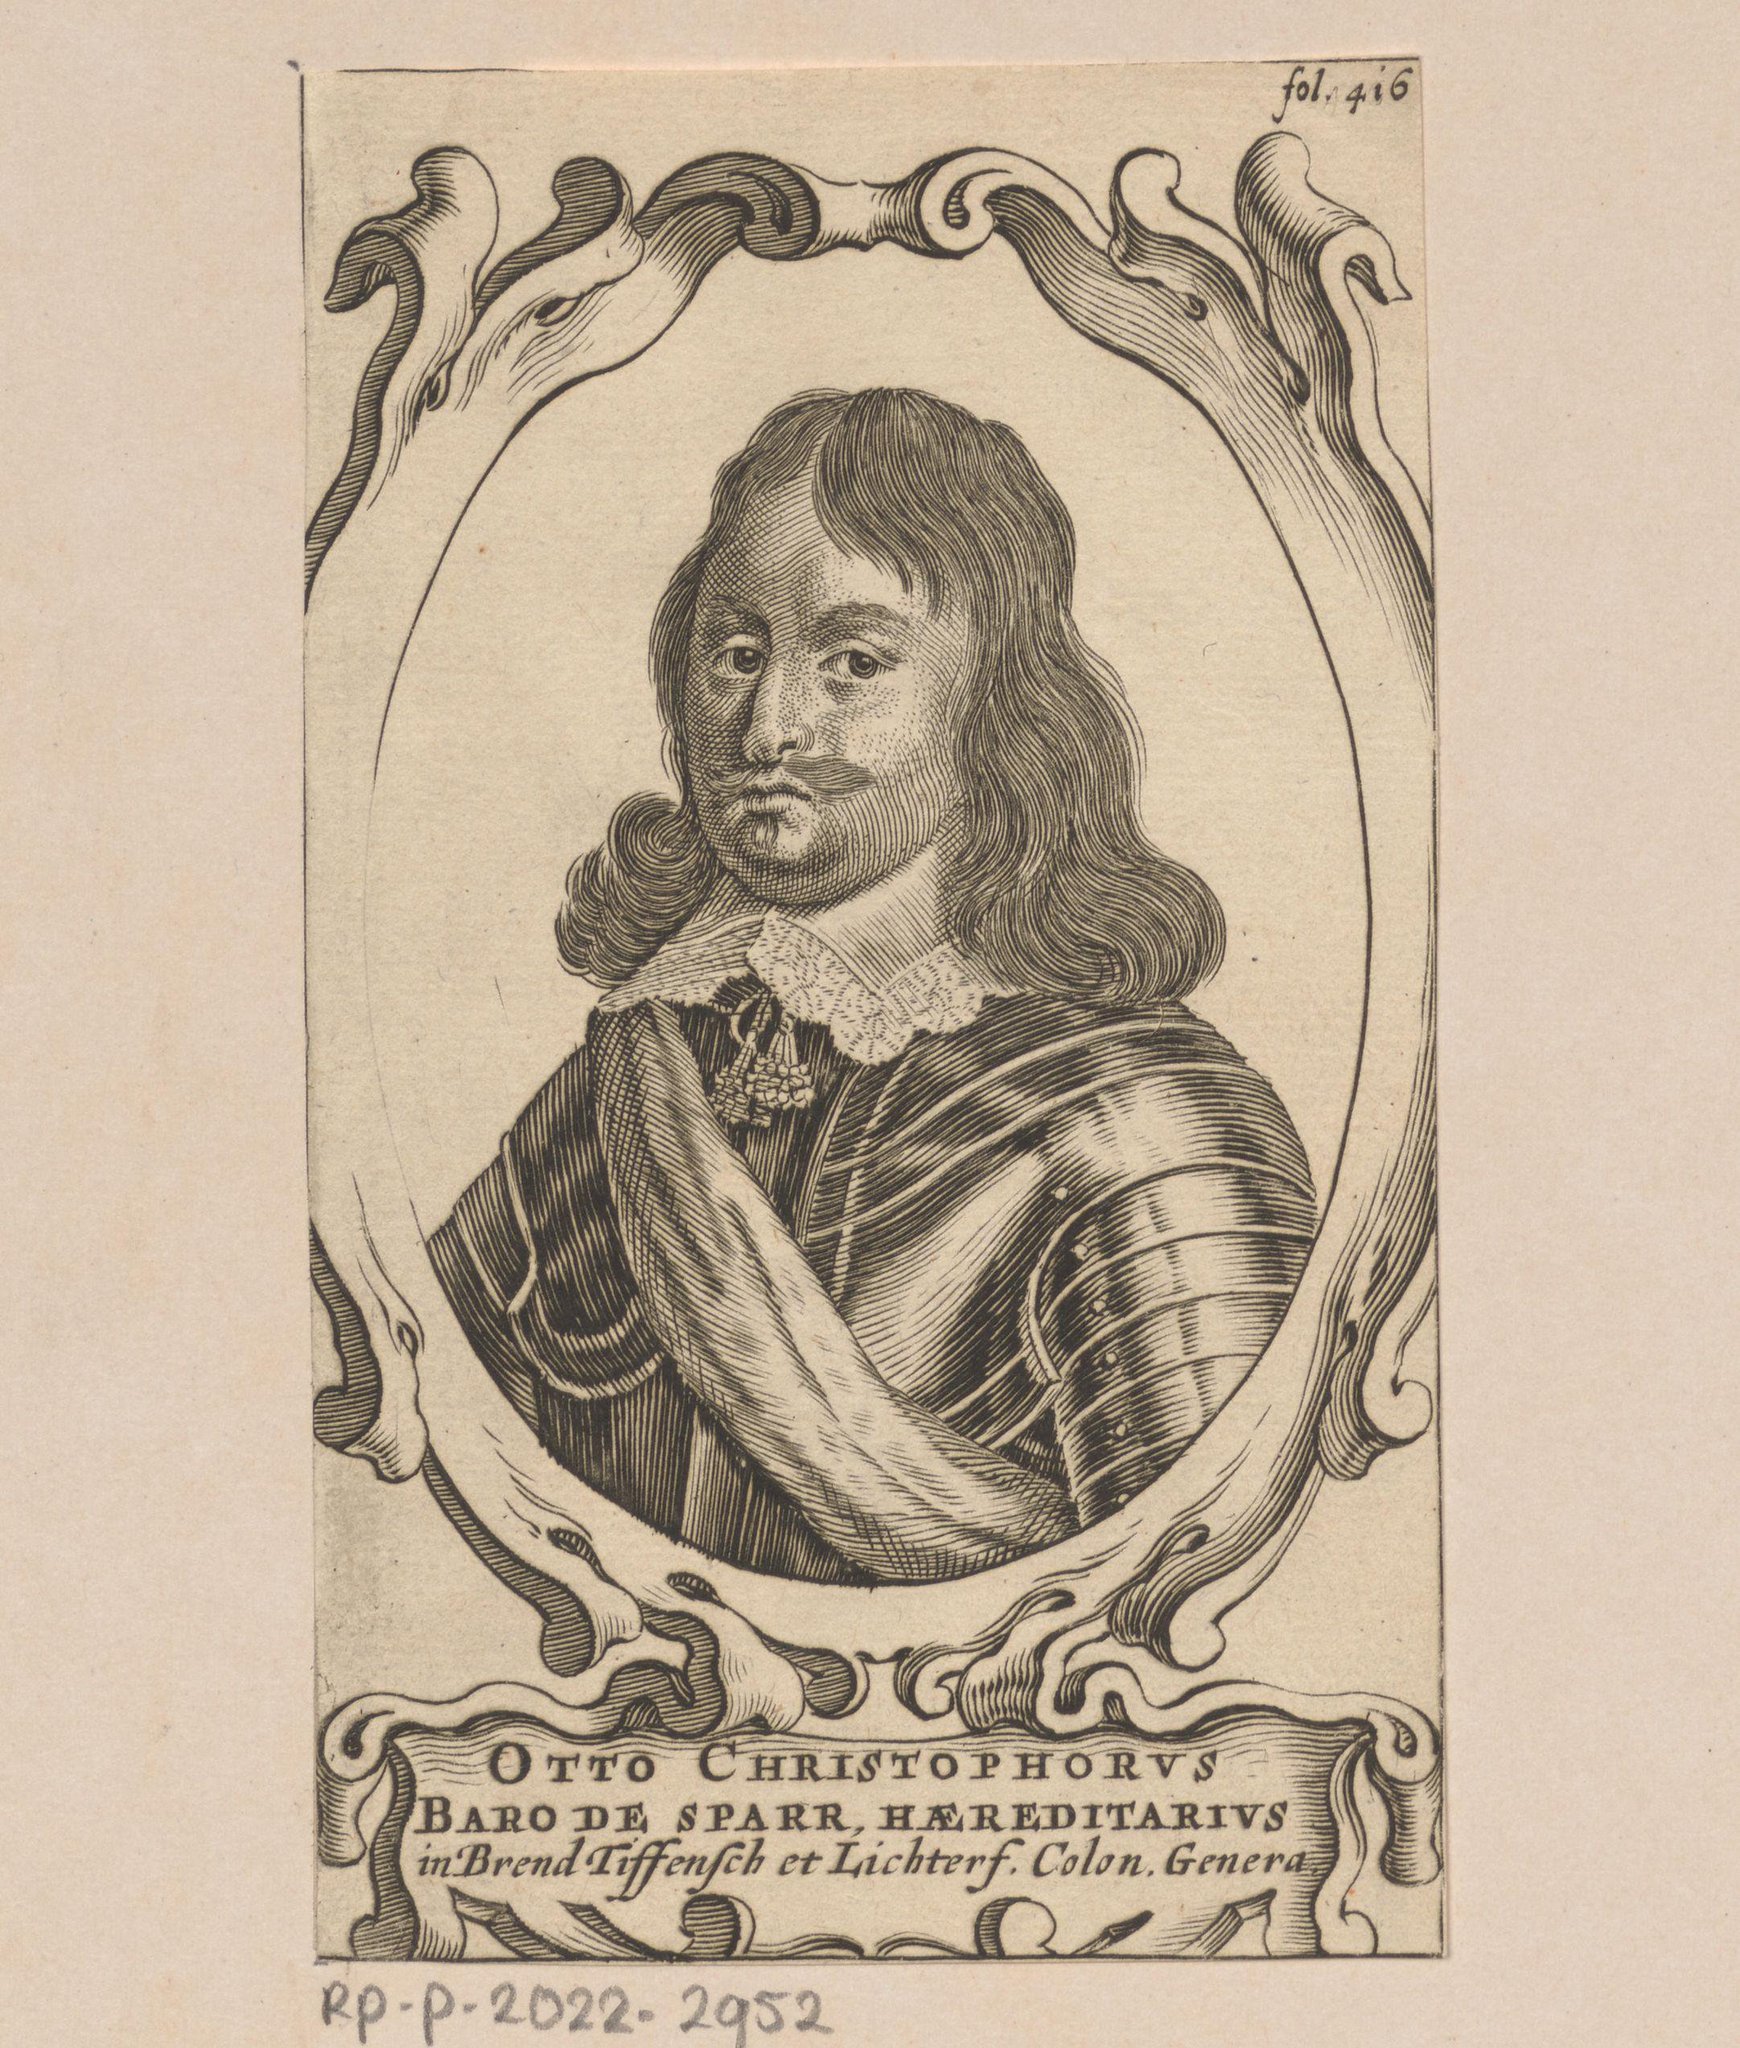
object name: print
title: Portret van Otto Christoph van Sparr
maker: Anonymous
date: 1656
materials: paper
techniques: engraving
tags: other sovereign (baron), commander-in-chief, general, marshal, historical persons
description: Prent waarschijnlijk uit: Brachelius, Johannes Adolphus. Historia nostri temporis, dat is geschiedenis onses tijdts (…). Rotterdam: Andries van Hoogenhuysen, 1656. Prent ook gebruikt in de 1659- en 1666-editie.